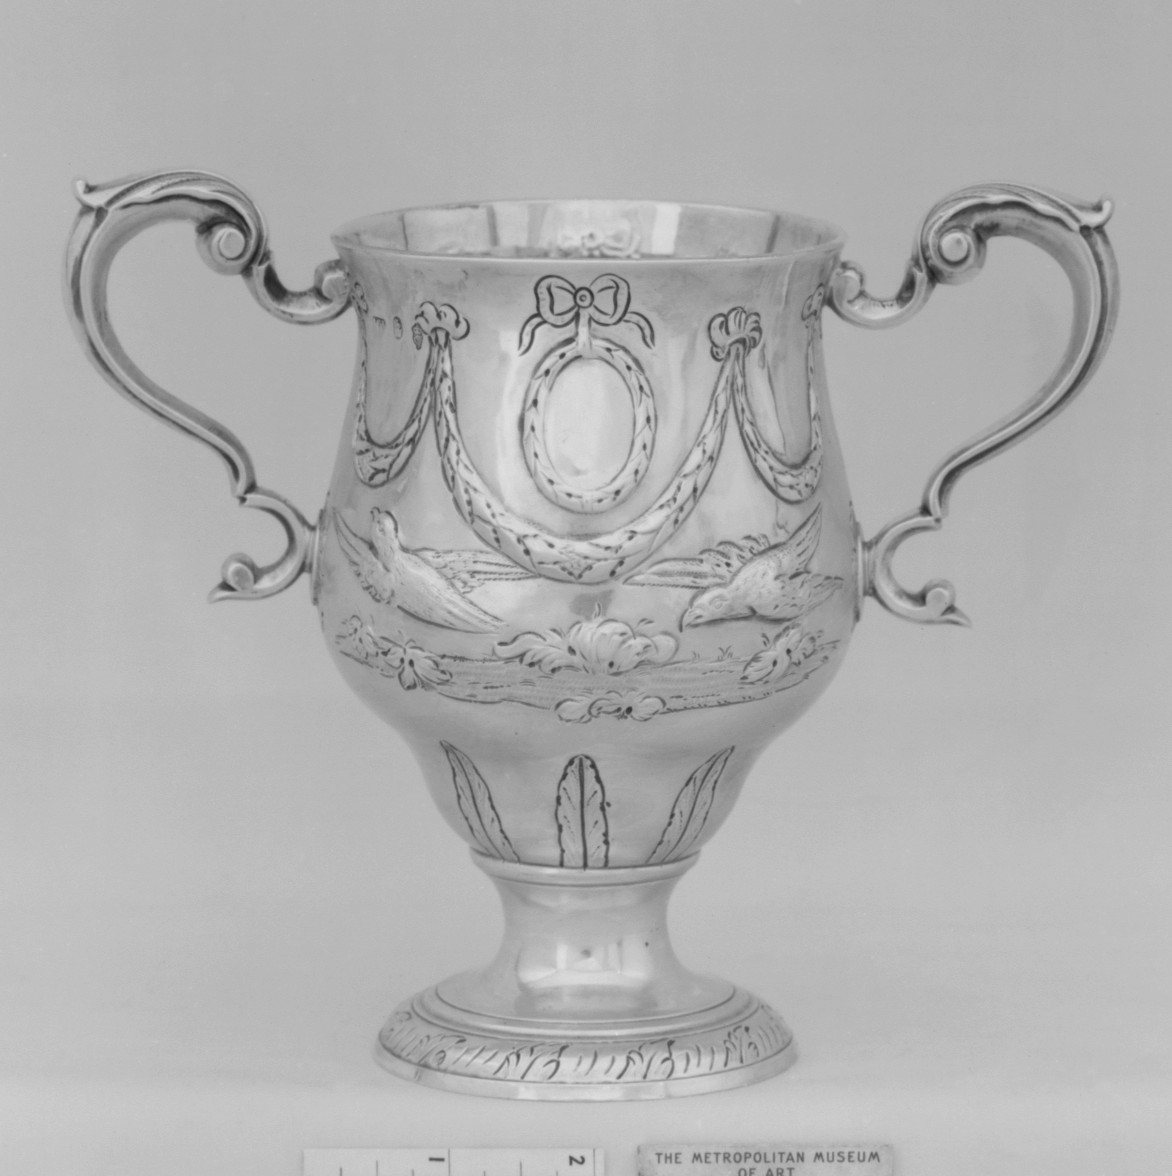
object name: cup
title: Two-handled cup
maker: matthew west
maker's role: maker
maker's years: 1725-1825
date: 1775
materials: silver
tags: birds